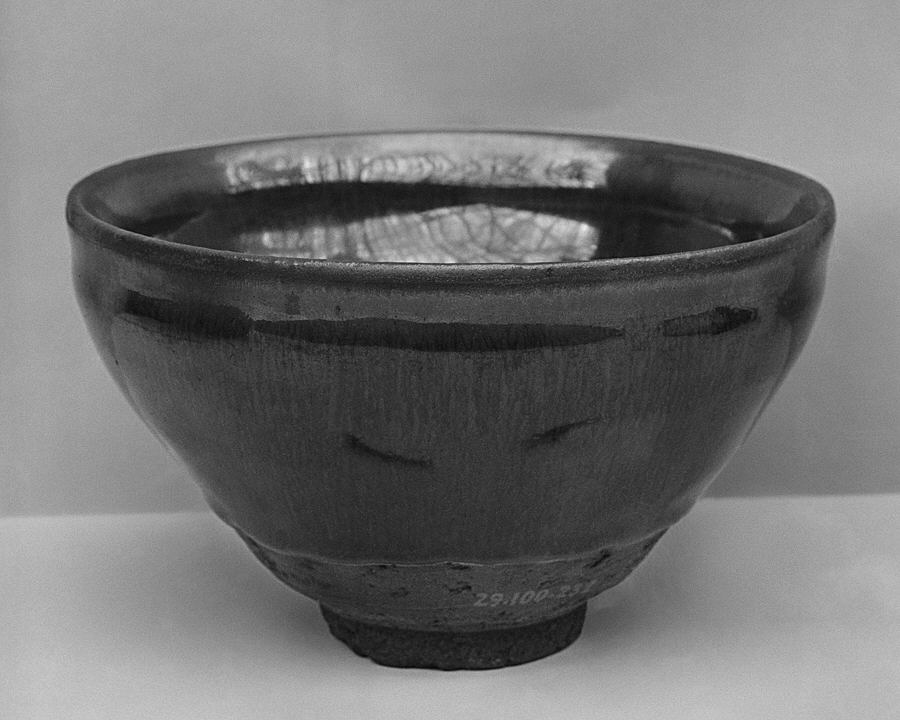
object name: bowl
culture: chinese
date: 1271-1368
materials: glaze